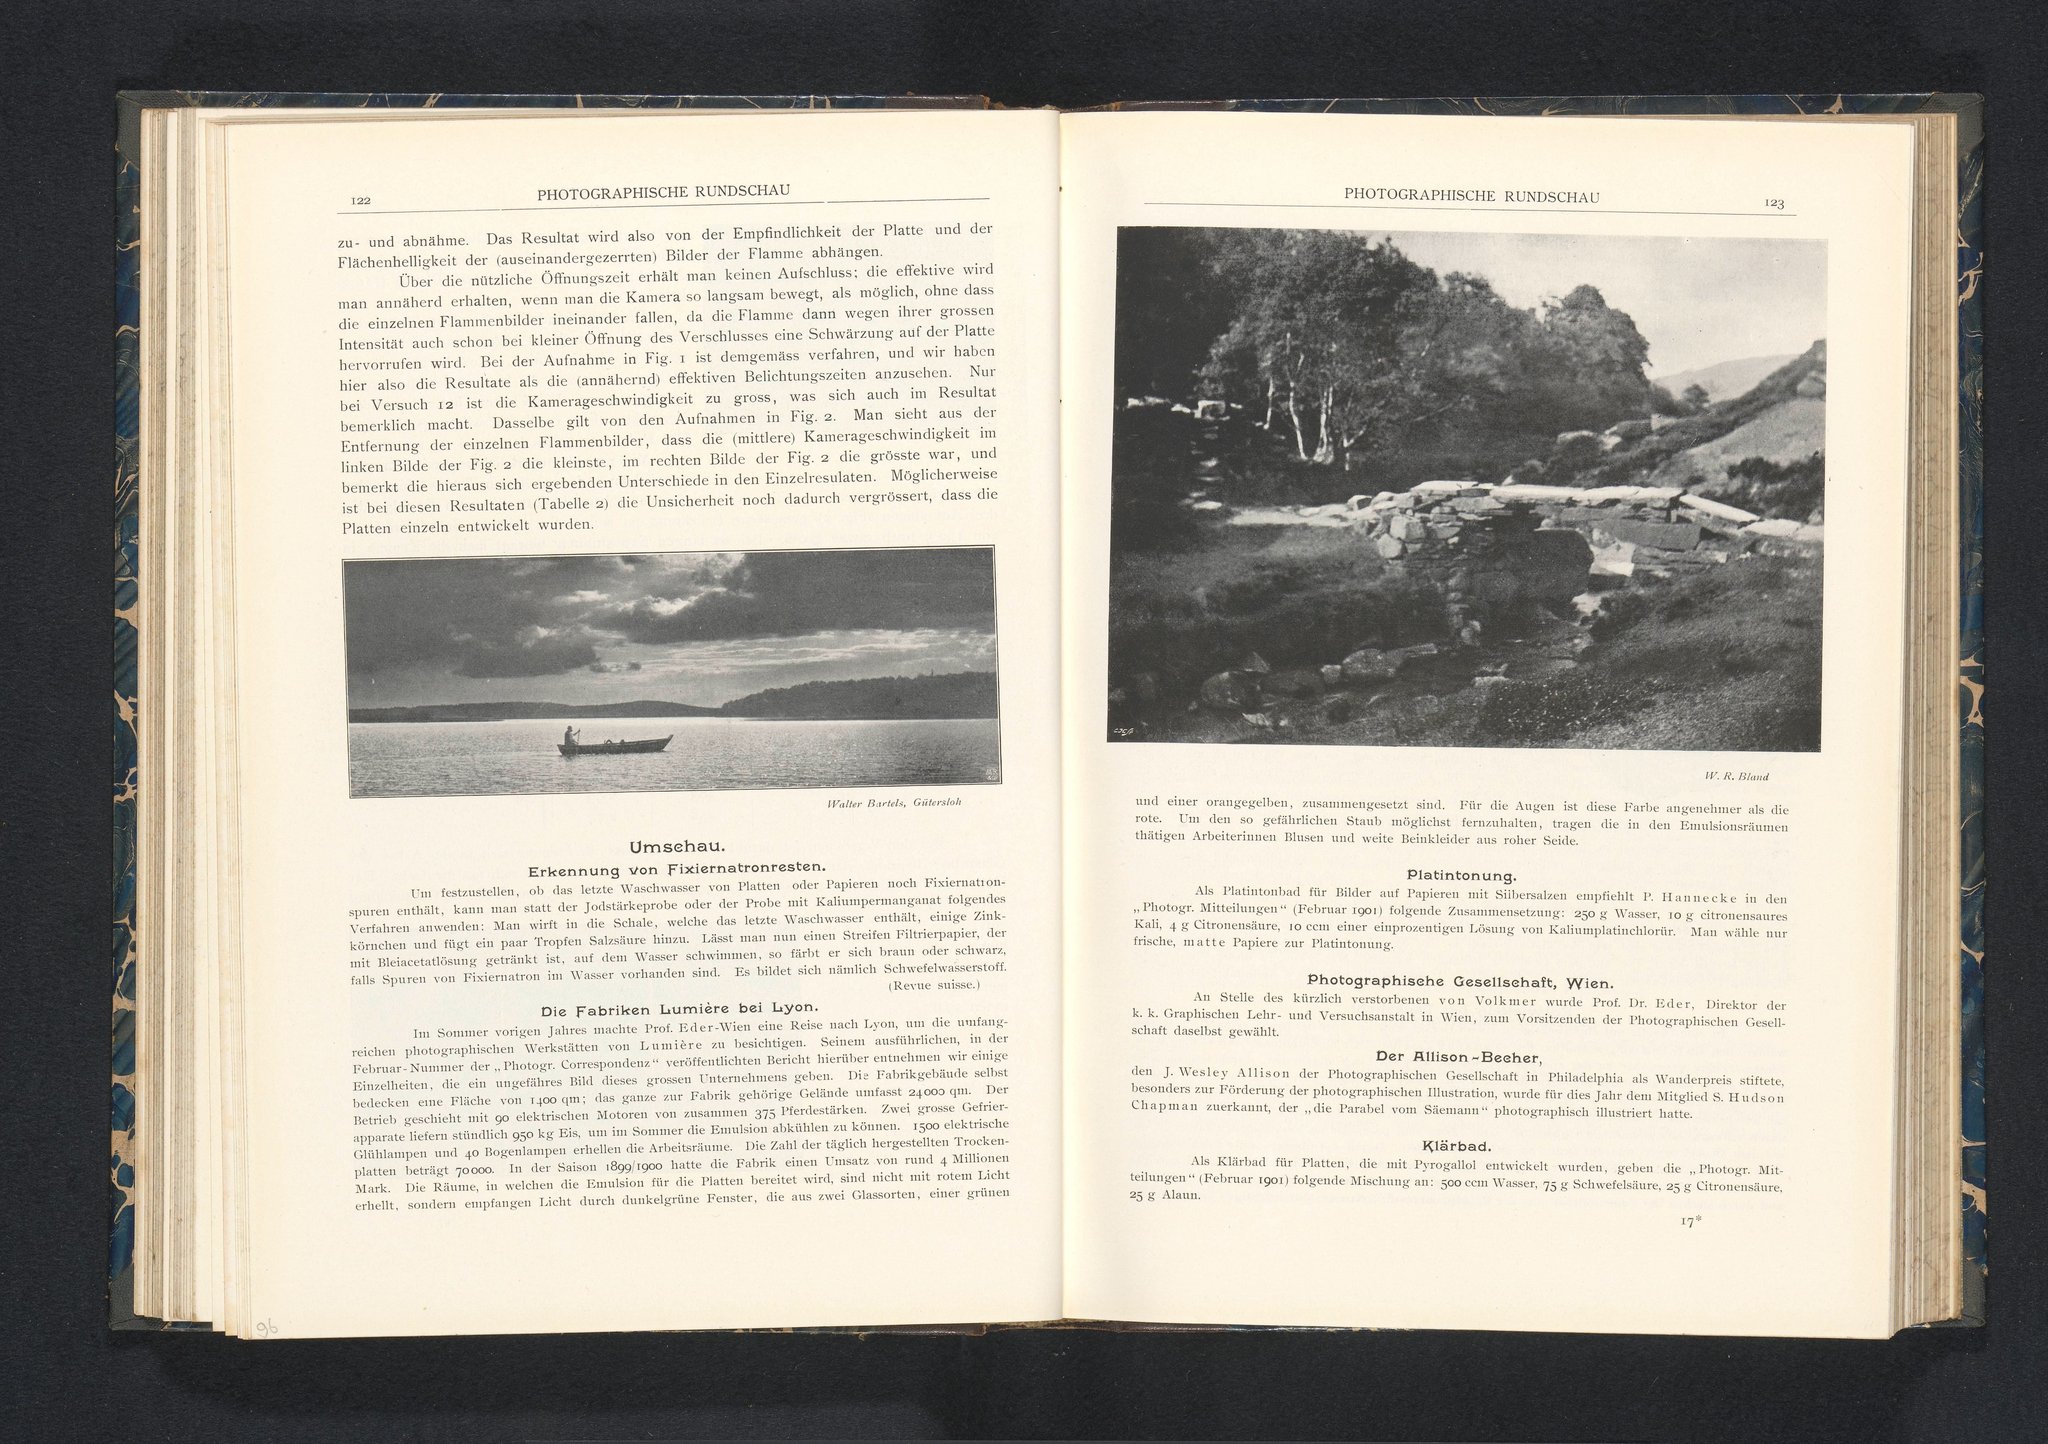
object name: photomechanical print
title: Landschap met stenen brug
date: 1896-1901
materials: paper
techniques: autotype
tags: landscapes, bridge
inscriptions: monogram: ‘CH[..]’